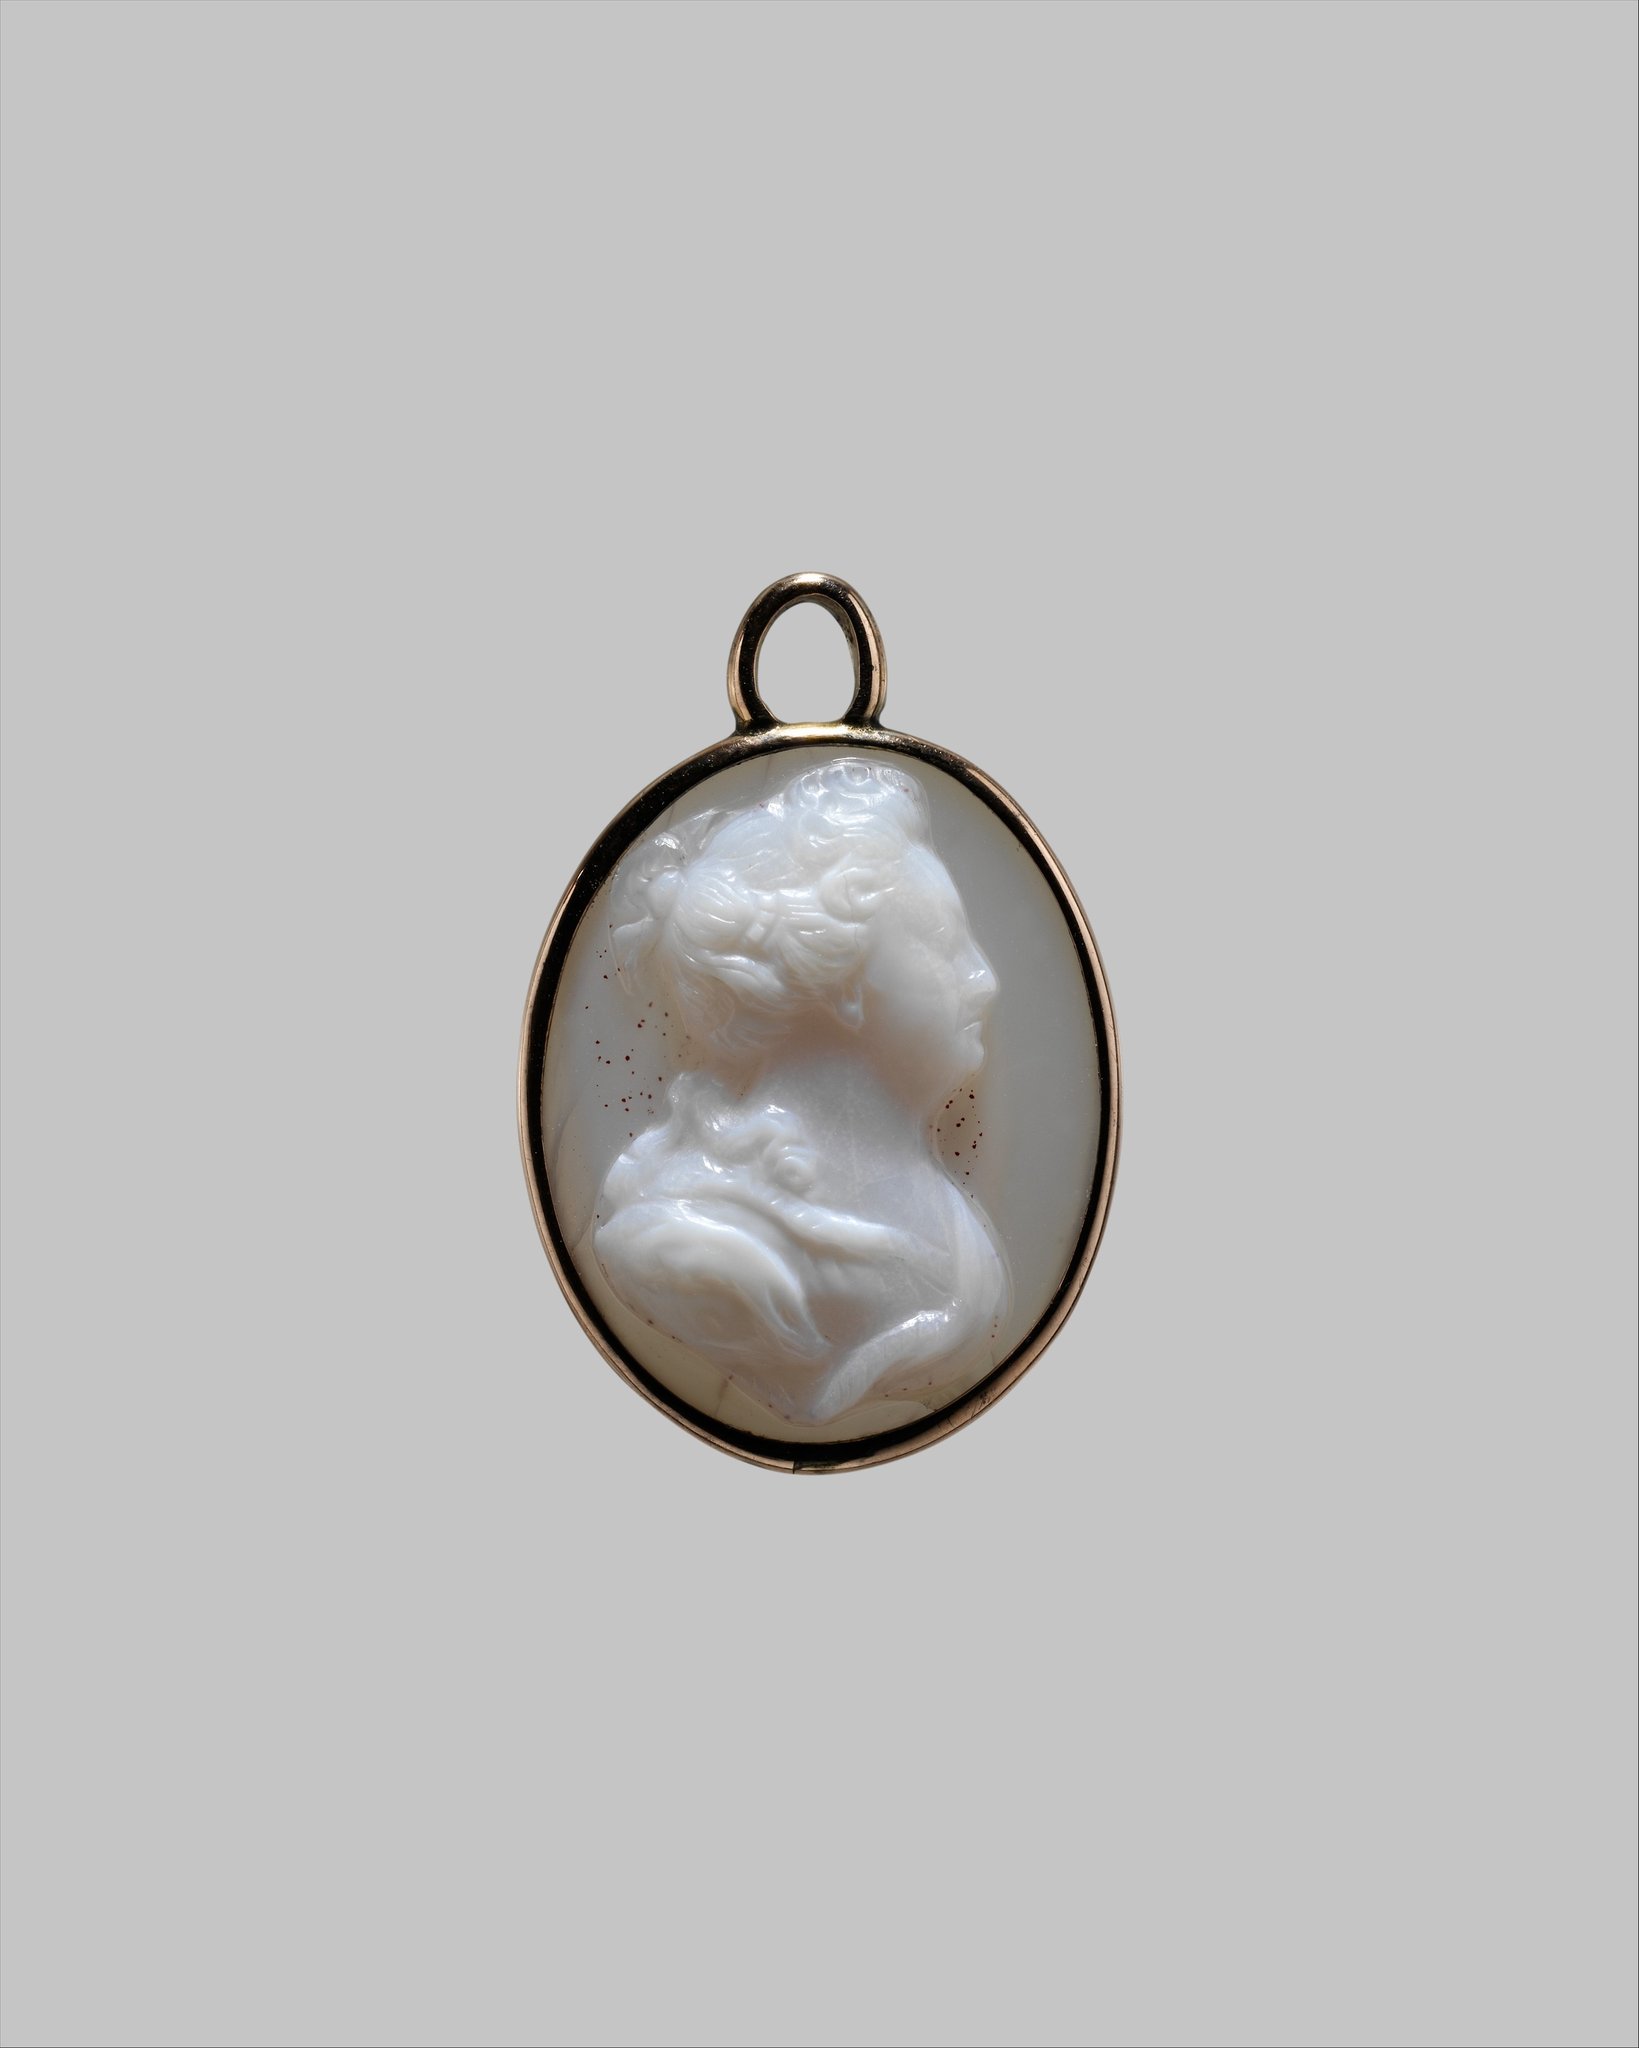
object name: cameo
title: Catherine the Great of Russia (1729–1796)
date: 1790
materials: gold, onyx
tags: profiles,women